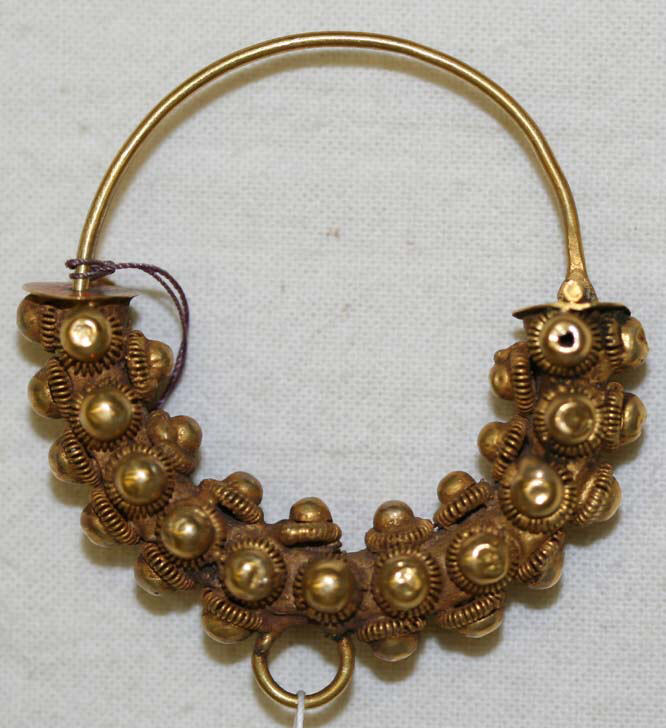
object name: earring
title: Earrings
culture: european, eastern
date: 1701-1900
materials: metal